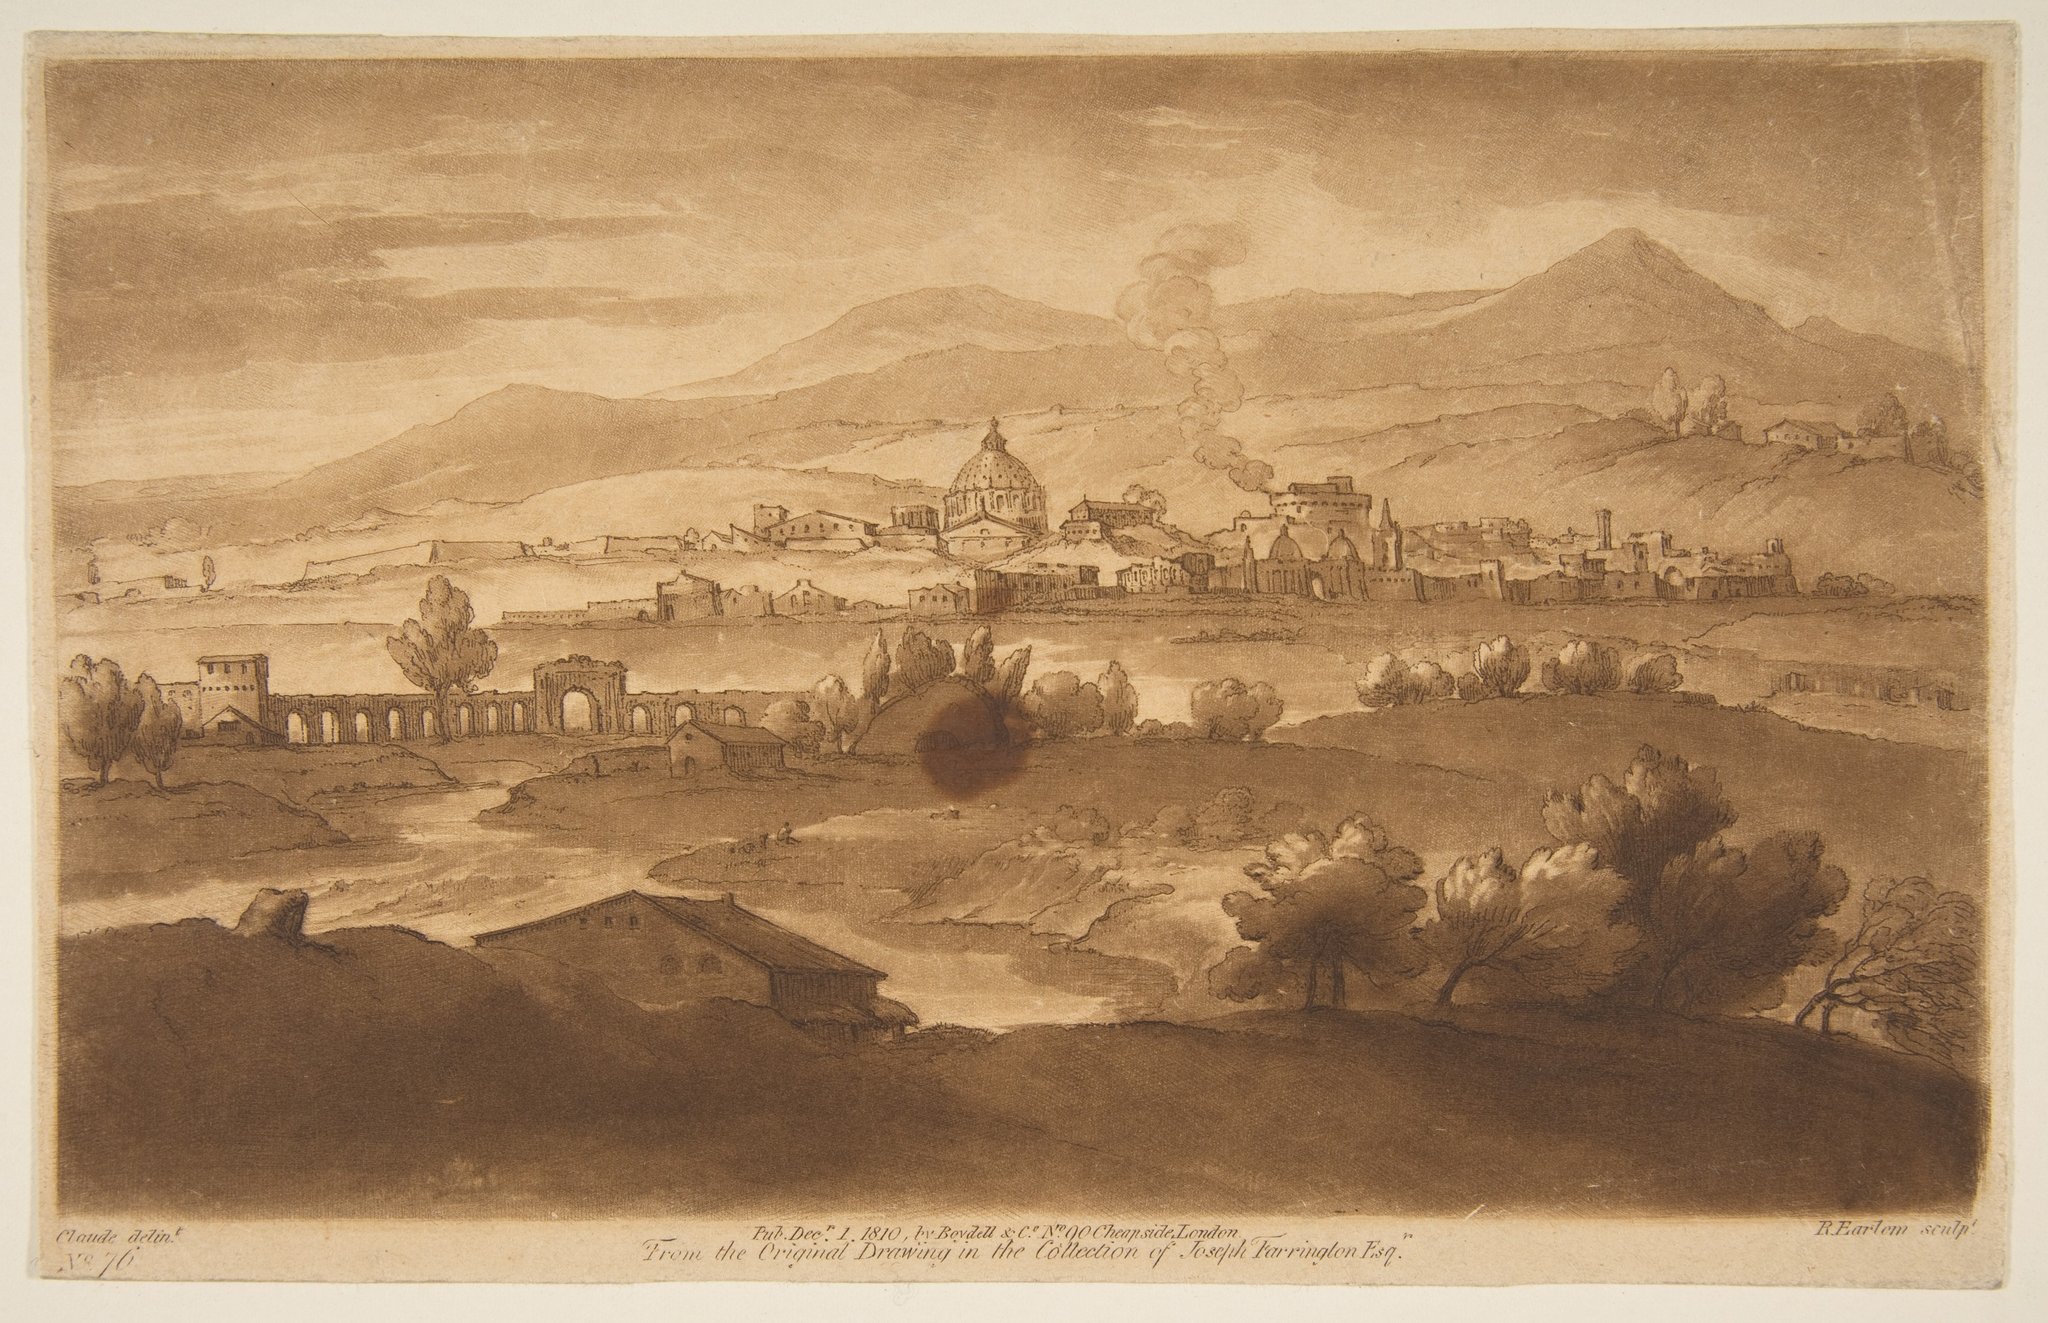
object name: print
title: View of Rome and Surrounding Country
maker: richard earlom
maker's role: engraver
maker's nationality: british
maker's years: 1743-1822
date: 1810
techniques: etching, mezzotint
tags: buildings,mountains,landscapes,rome